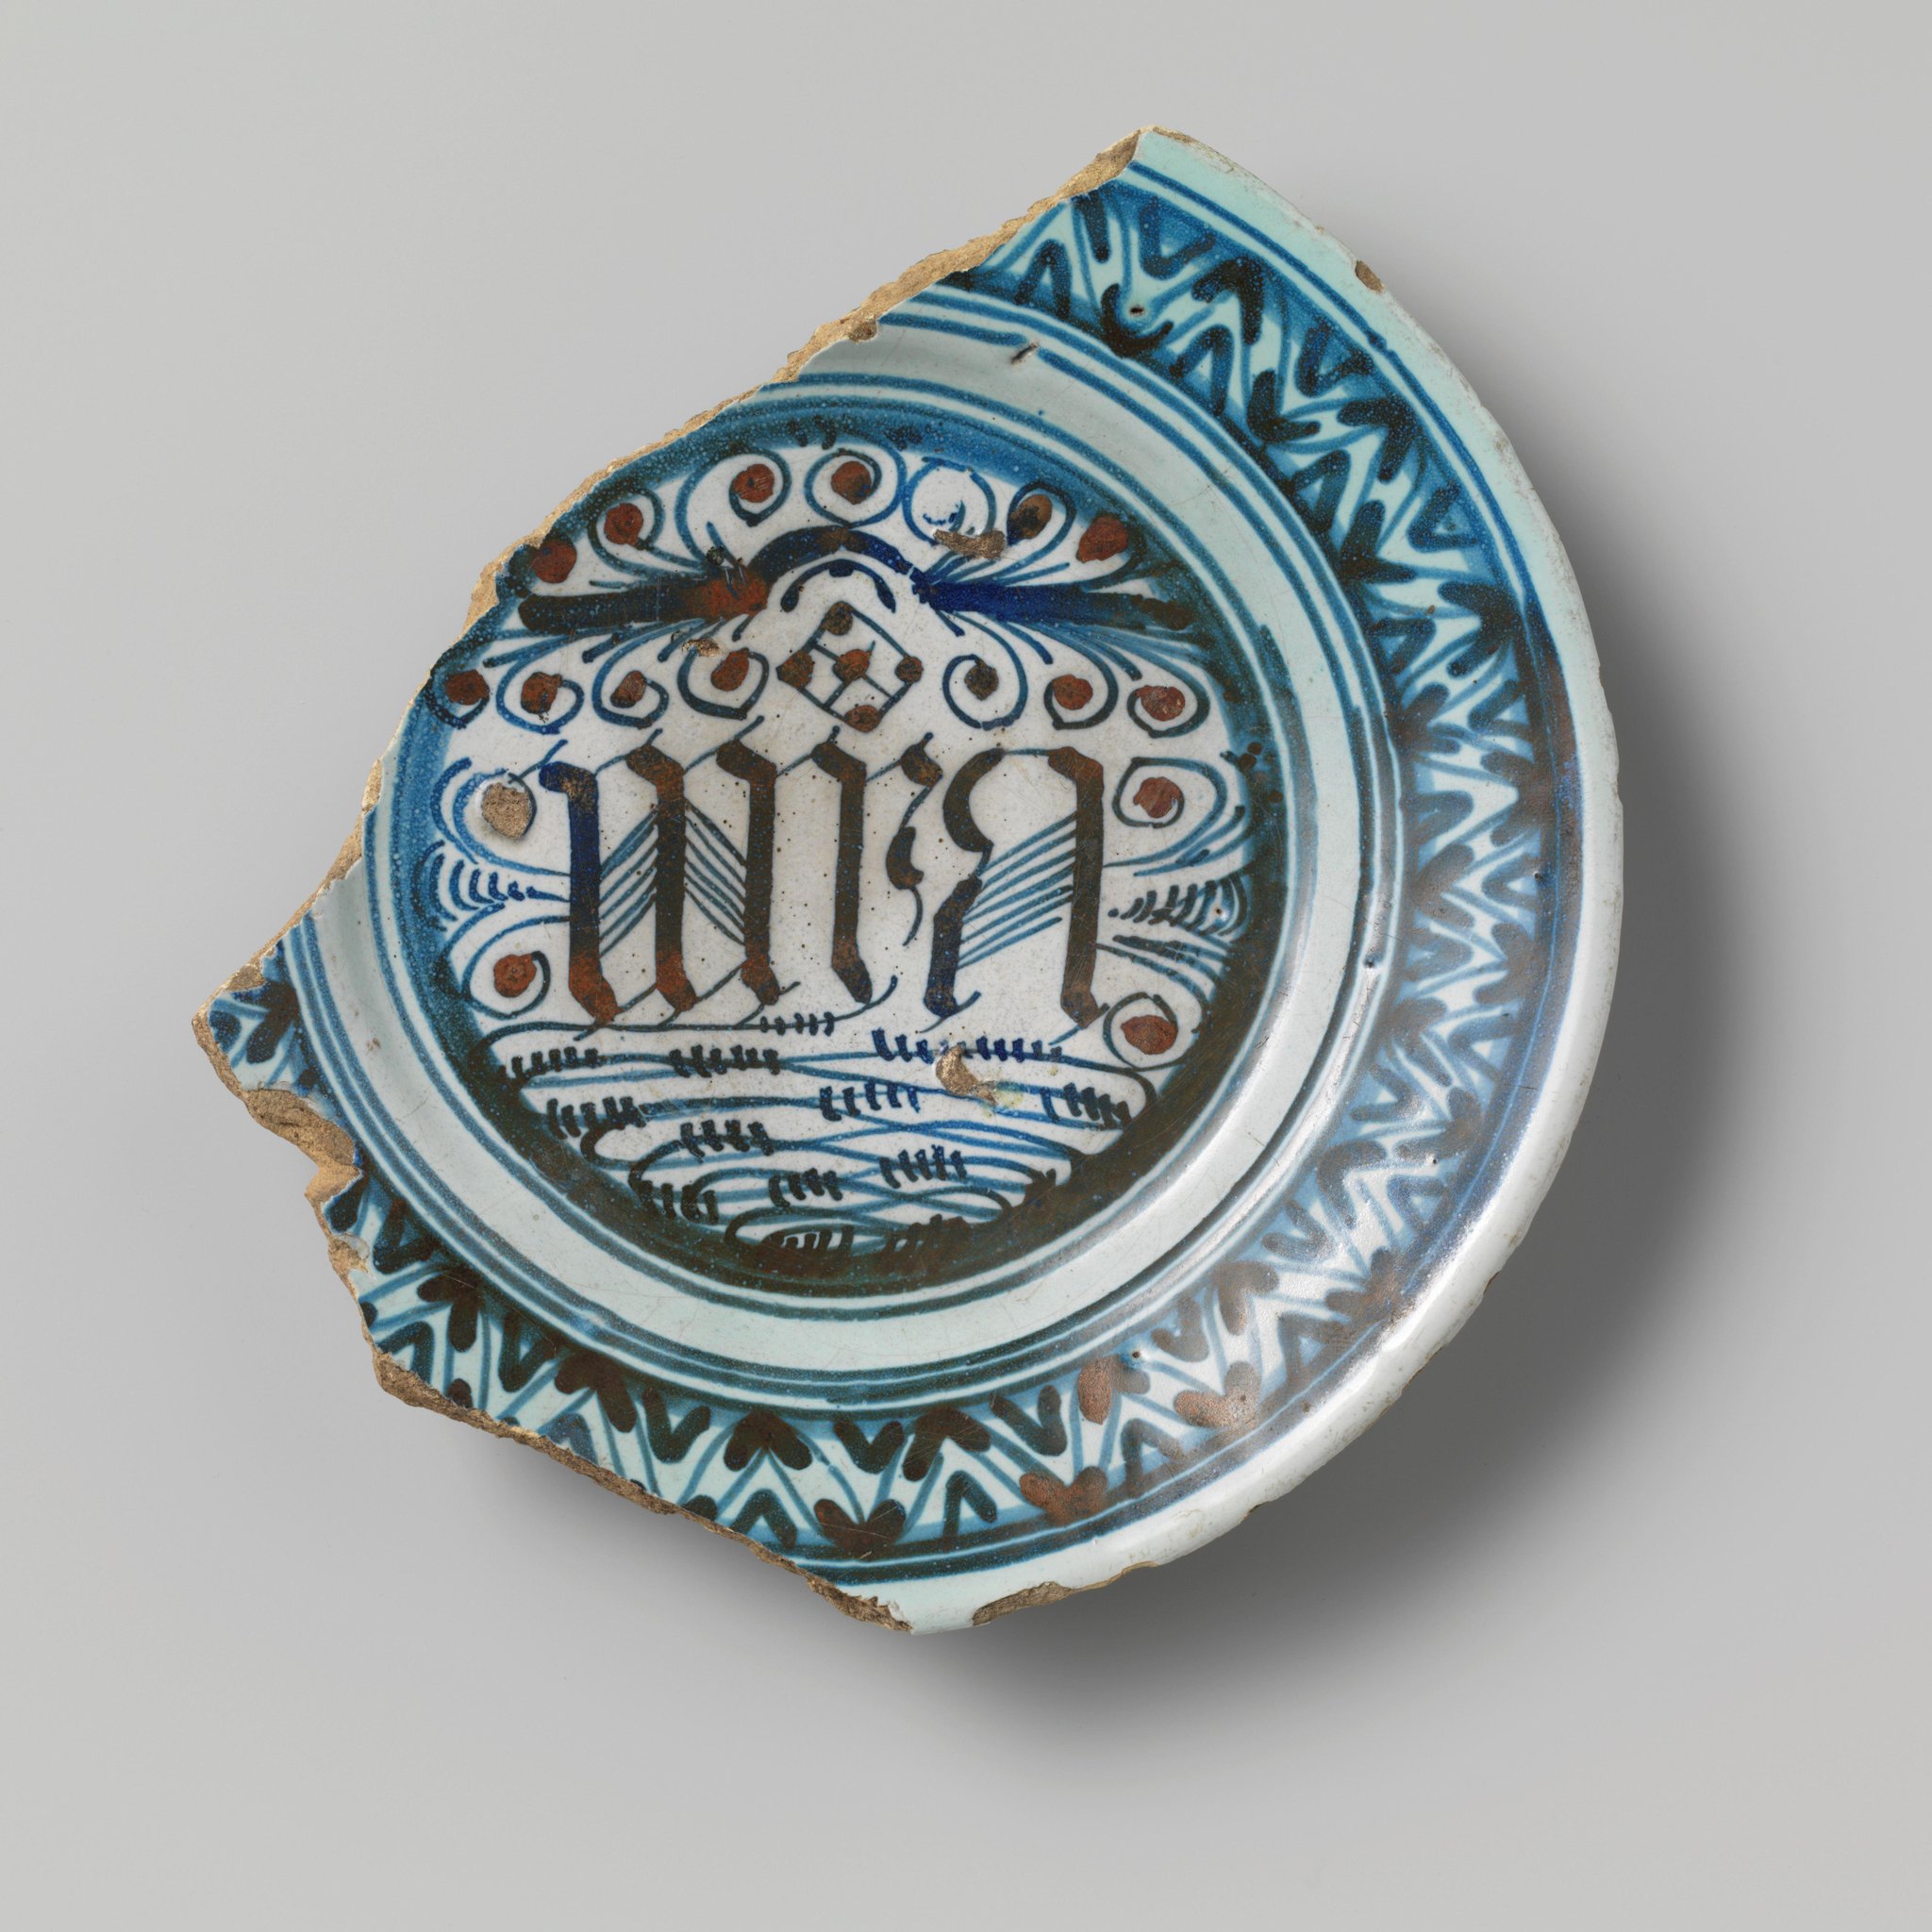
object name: plate dish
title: Bord van aardewerk, voorzien van loodglazuur aan de onderzijde en tinglazuur aan de bovenzijde, en in blauw onder andere de letters omega M A, beschadigd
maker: Anonymous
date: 1500-1799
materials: earthenware, glaze